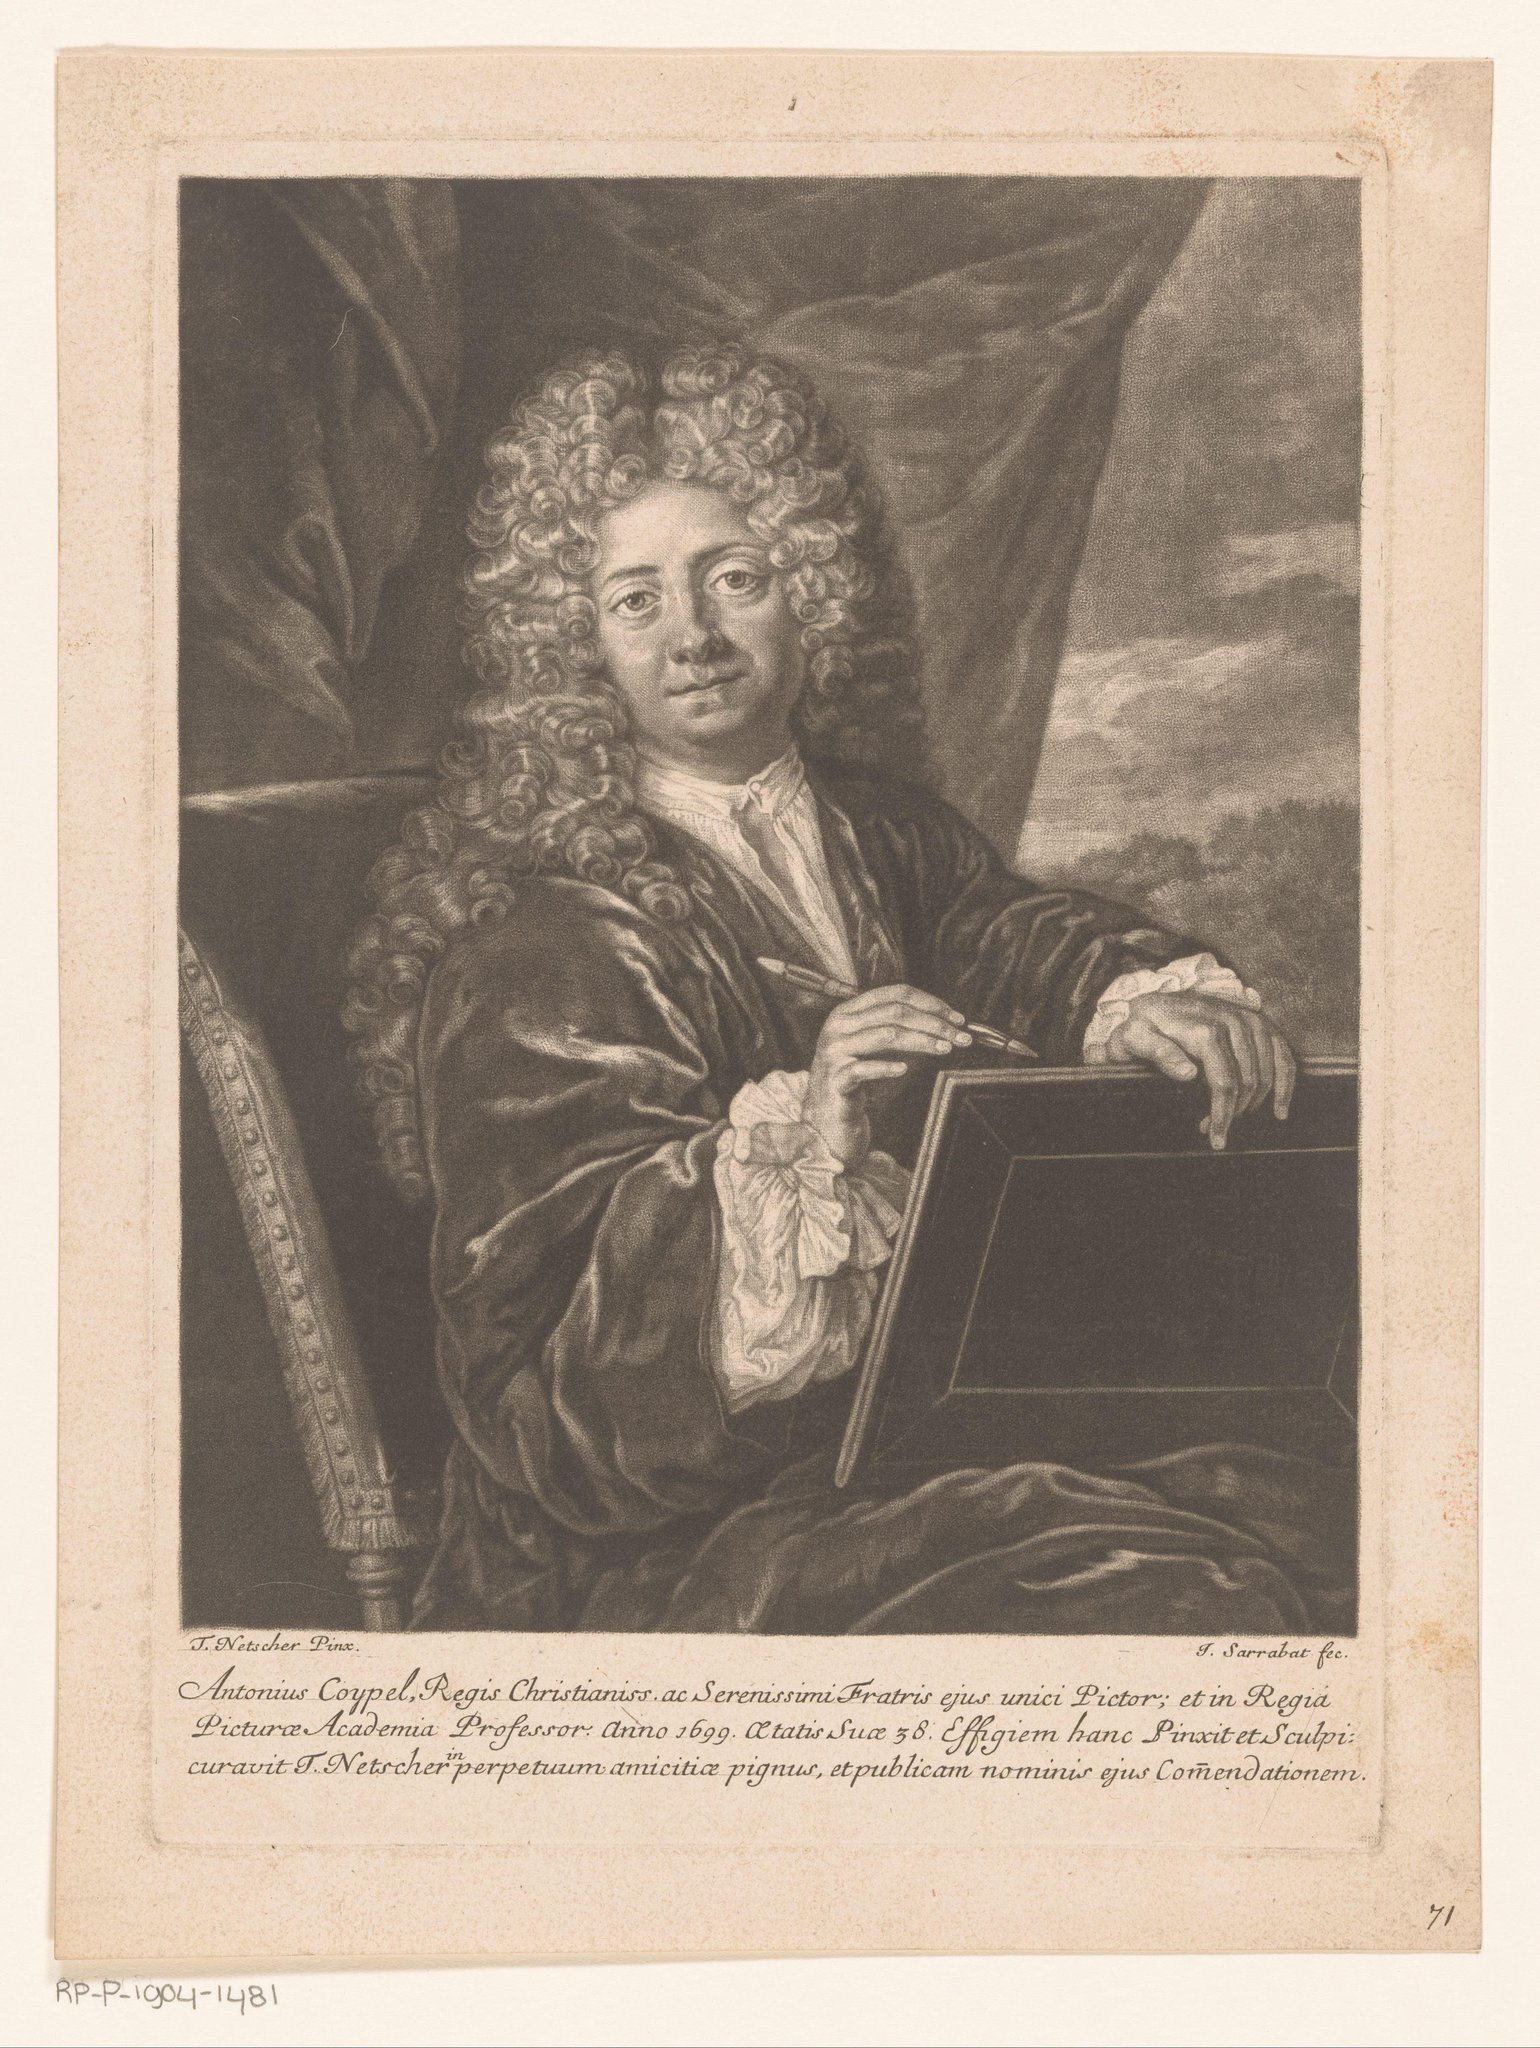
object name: print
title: Portret van Antoine Coypel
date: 1677-1701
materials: paper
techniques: mezzotint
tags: paris, print maker, draughtsman, antoine coypel, historical persons, portrait, self-portrait of painter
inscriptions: collector's mark: Lugt 2028, collector's mark: Lugt 2228